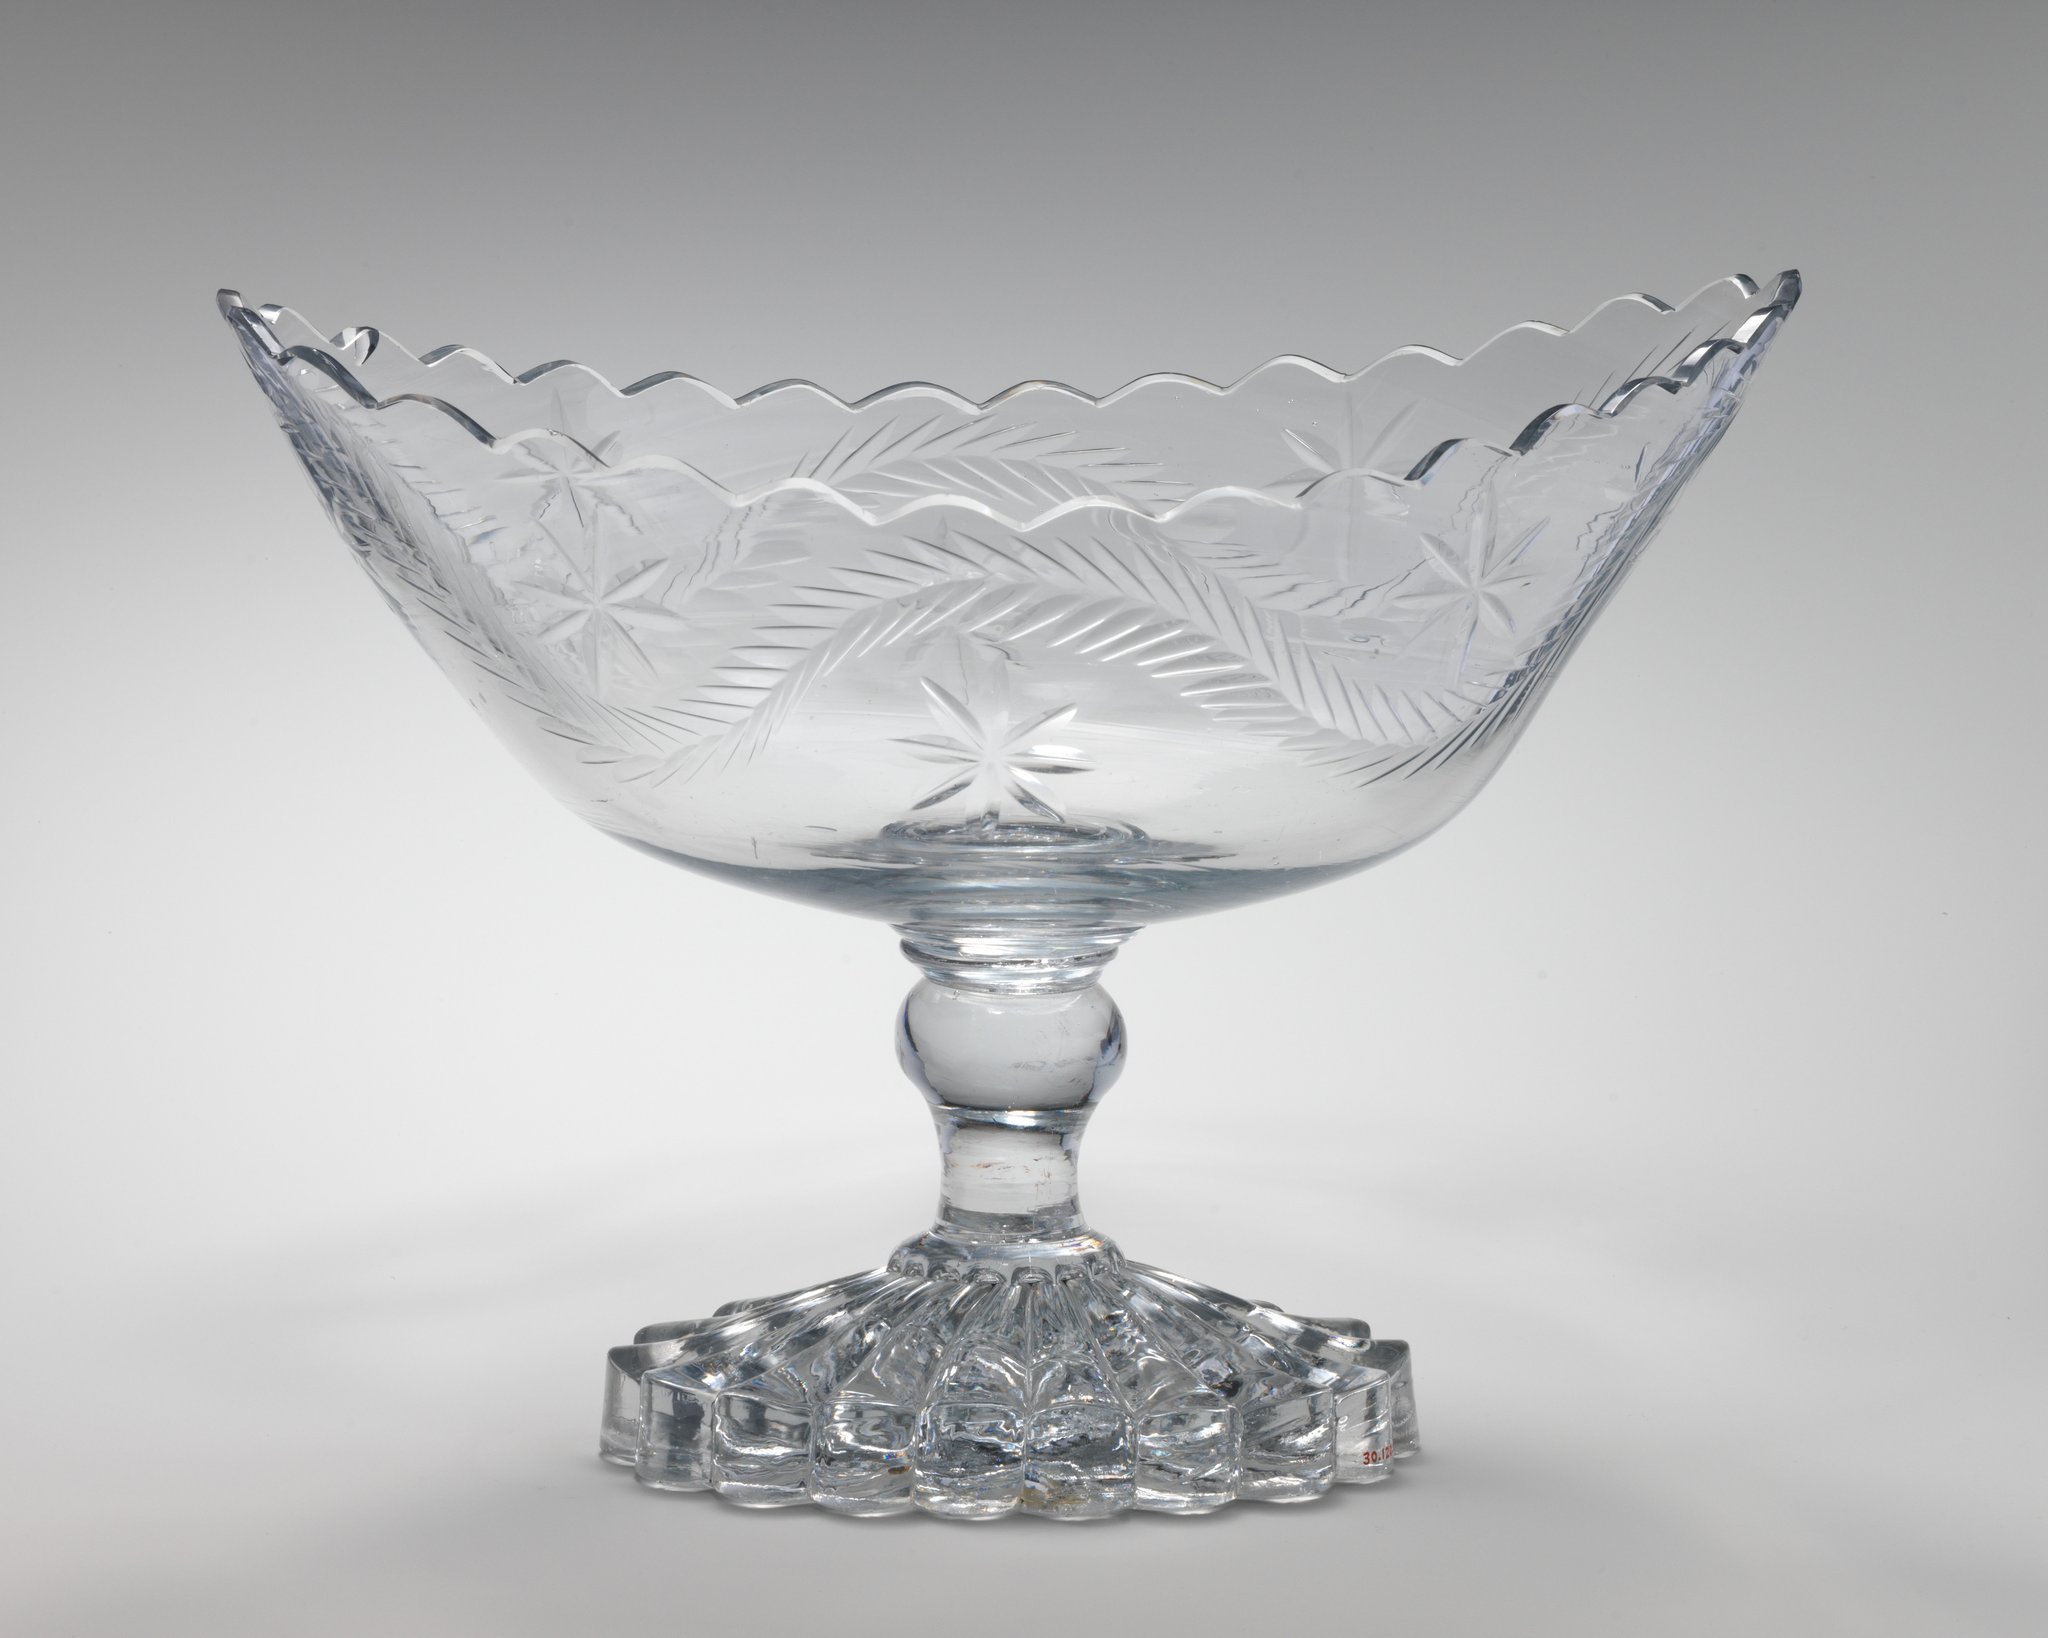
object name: fruit bowl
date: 1767-1833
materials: glass